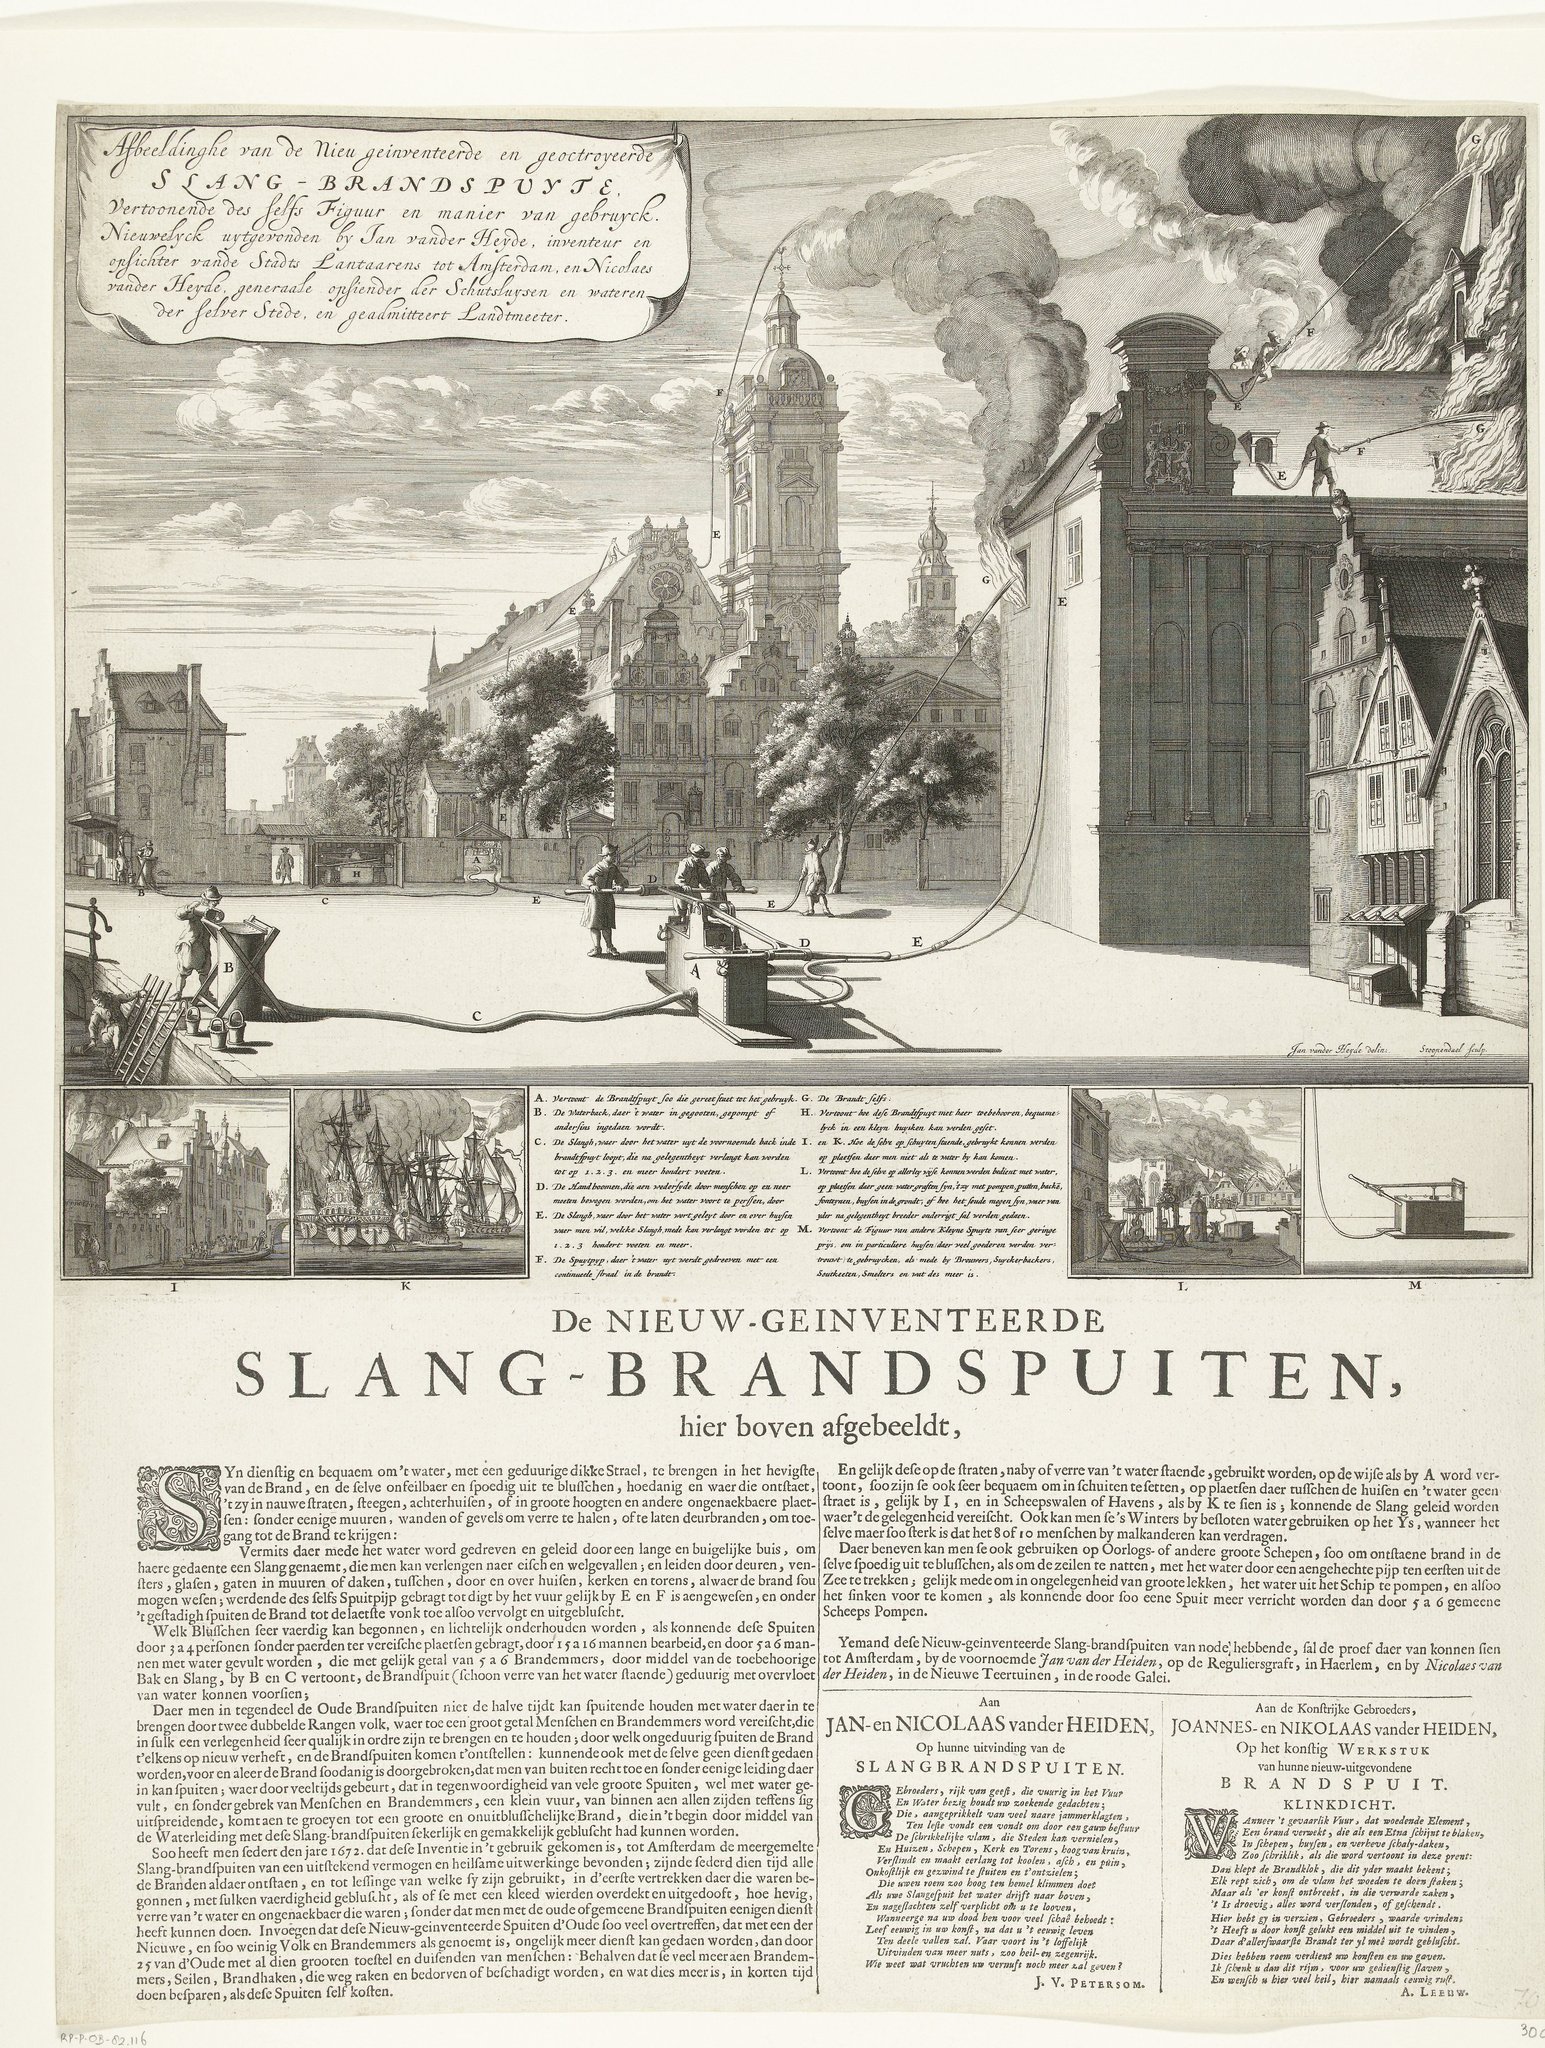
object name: print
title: Toepassing van de nieuwe brandspuitslangen, 1677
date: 1675-1677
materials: paper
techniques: etching, letterpress printing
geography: northern netherlands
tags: print maker, draughtsman, jan van der heyden, nicolaes van der heyden, fire-extinguishing equipment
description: Blad met een grote voorstelling van de toepassing van de nieuwe slangbrandspuiten uitgevonden door Jan en Nicolaes van der Heyden bij het blussen van een brand in een gebouw in een imaginaire stad. Onderaan vier kleine voorstellingen van branden in huizen en op een schip en een model van de pomp. Hierbij de legenda A-M. Onder de plaat is op hetzelfde blad gedrukt een beschrijving in 2 kolommen met 2 lofdichten op de uitvinding van Jan en Nicolaes van der Heyden. Behoort tot de bijprenten bij het Brandspuitenboek van Jan van der Heyden.